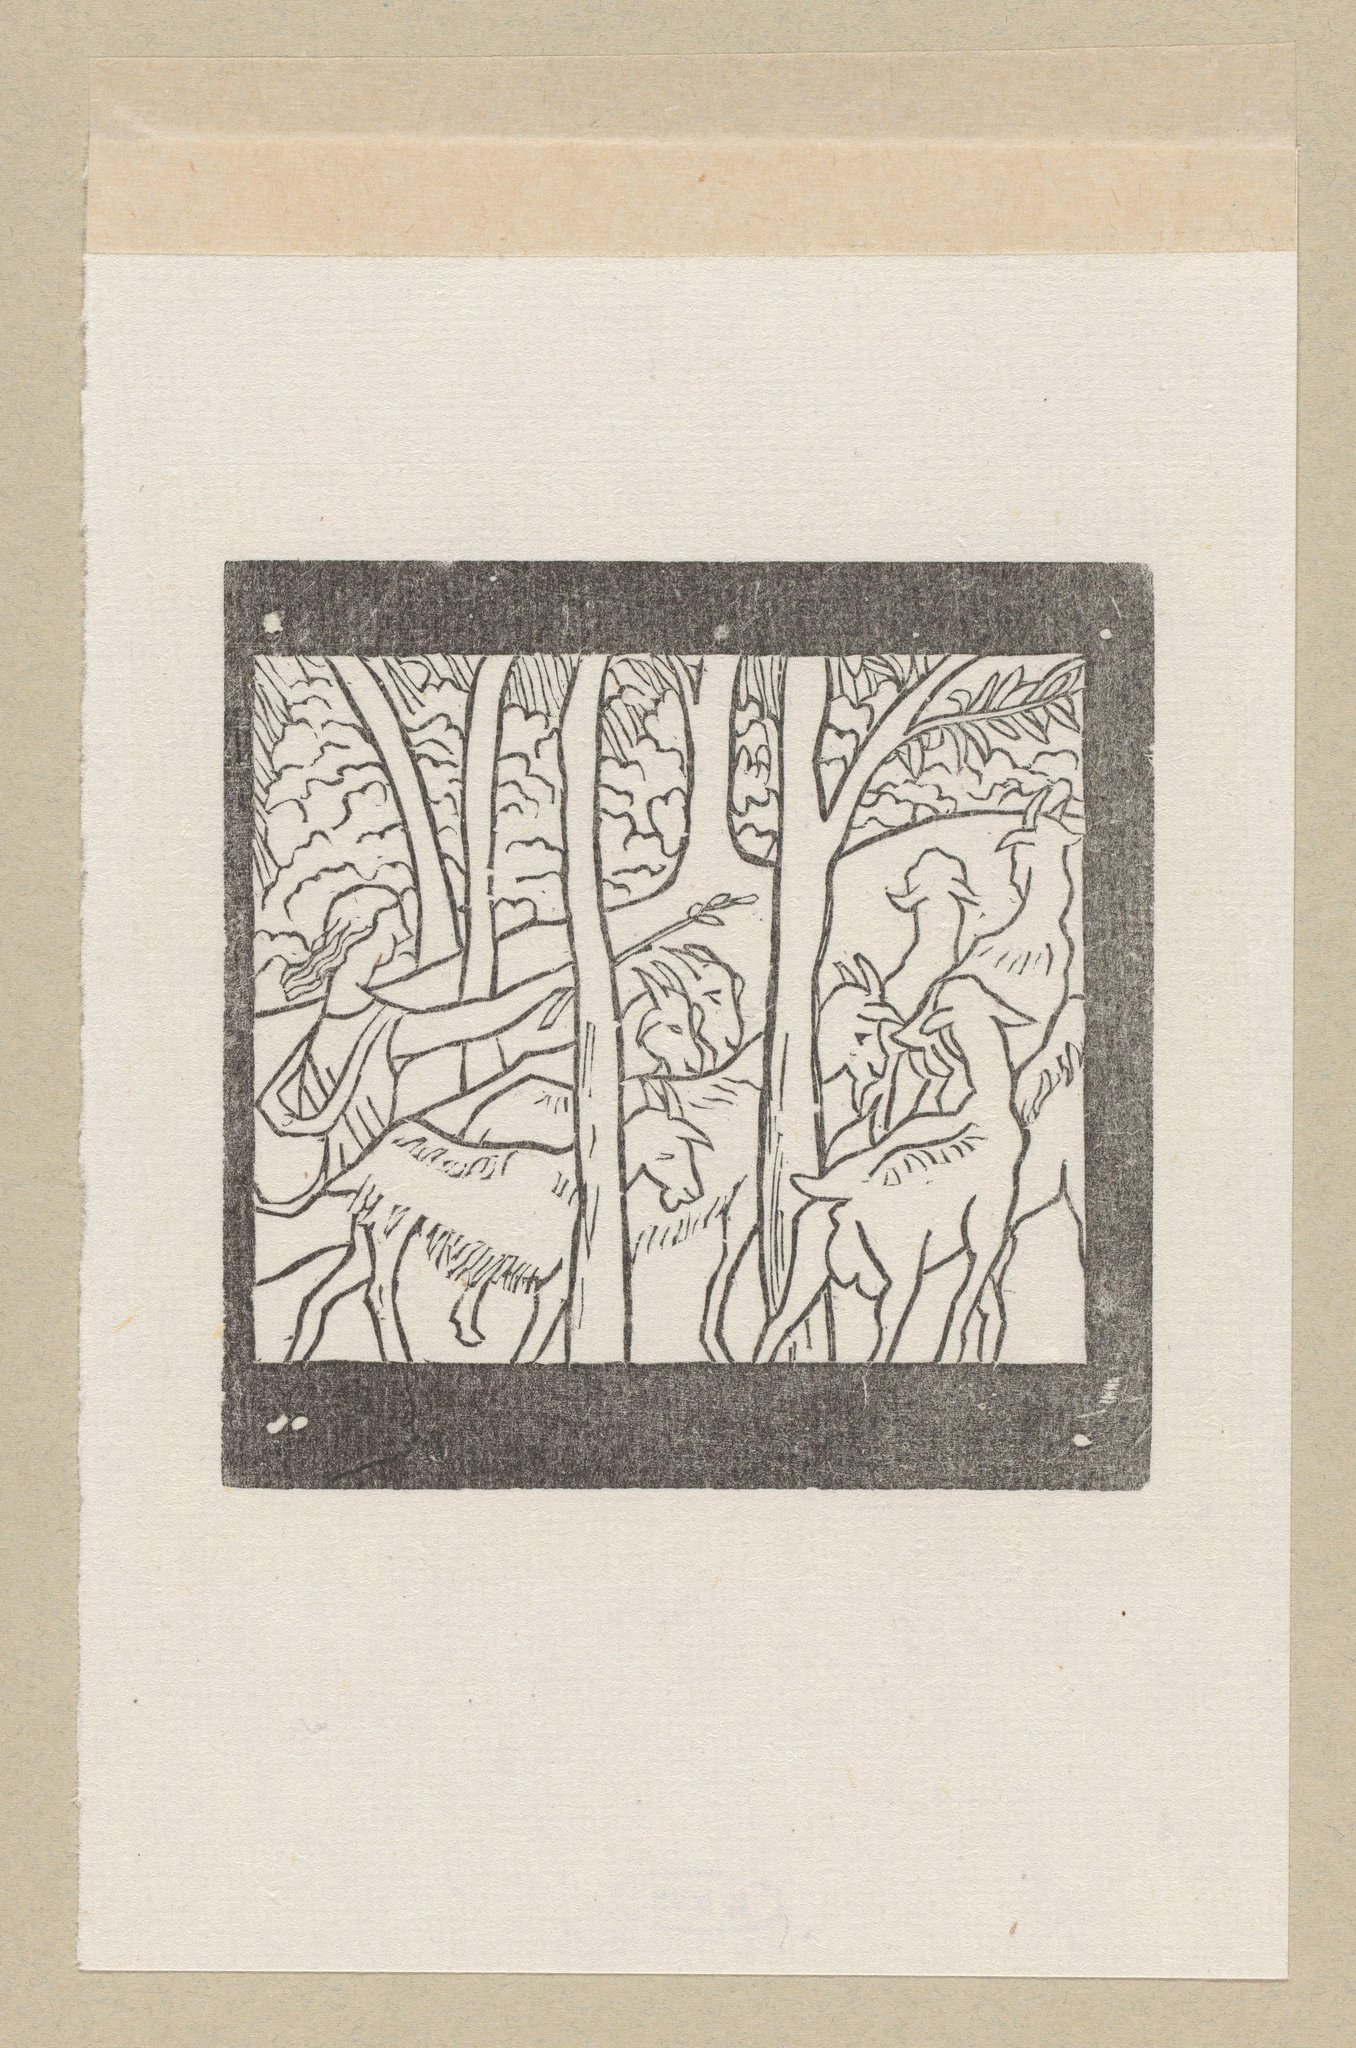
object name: book illustration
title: Daphnis ramène ses bêtes a l'étable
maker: aristide maillol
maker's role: draughtsman, painter, print maker, sculptor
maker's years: 1861-1944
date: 1937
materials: paper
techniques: woodcut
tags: daphnis (in greek mythology a shepherd who invented pastoral poetry, chloe, goat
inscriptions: collector's mark: Lugt 2228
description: Latere staat van deze prent gebruikt in: Longus. Les Pastorales de Longus ou Daphnis & Chloé. Parijs: Frères Gonin, 1935, p. 114.